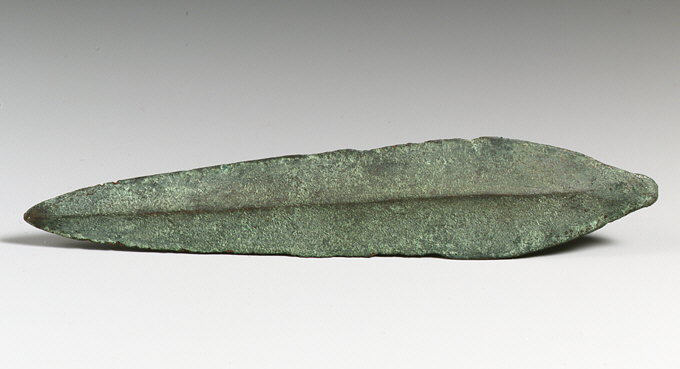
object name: dagger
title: Dagger blade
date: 7000 BCE-330 CE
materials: bronze